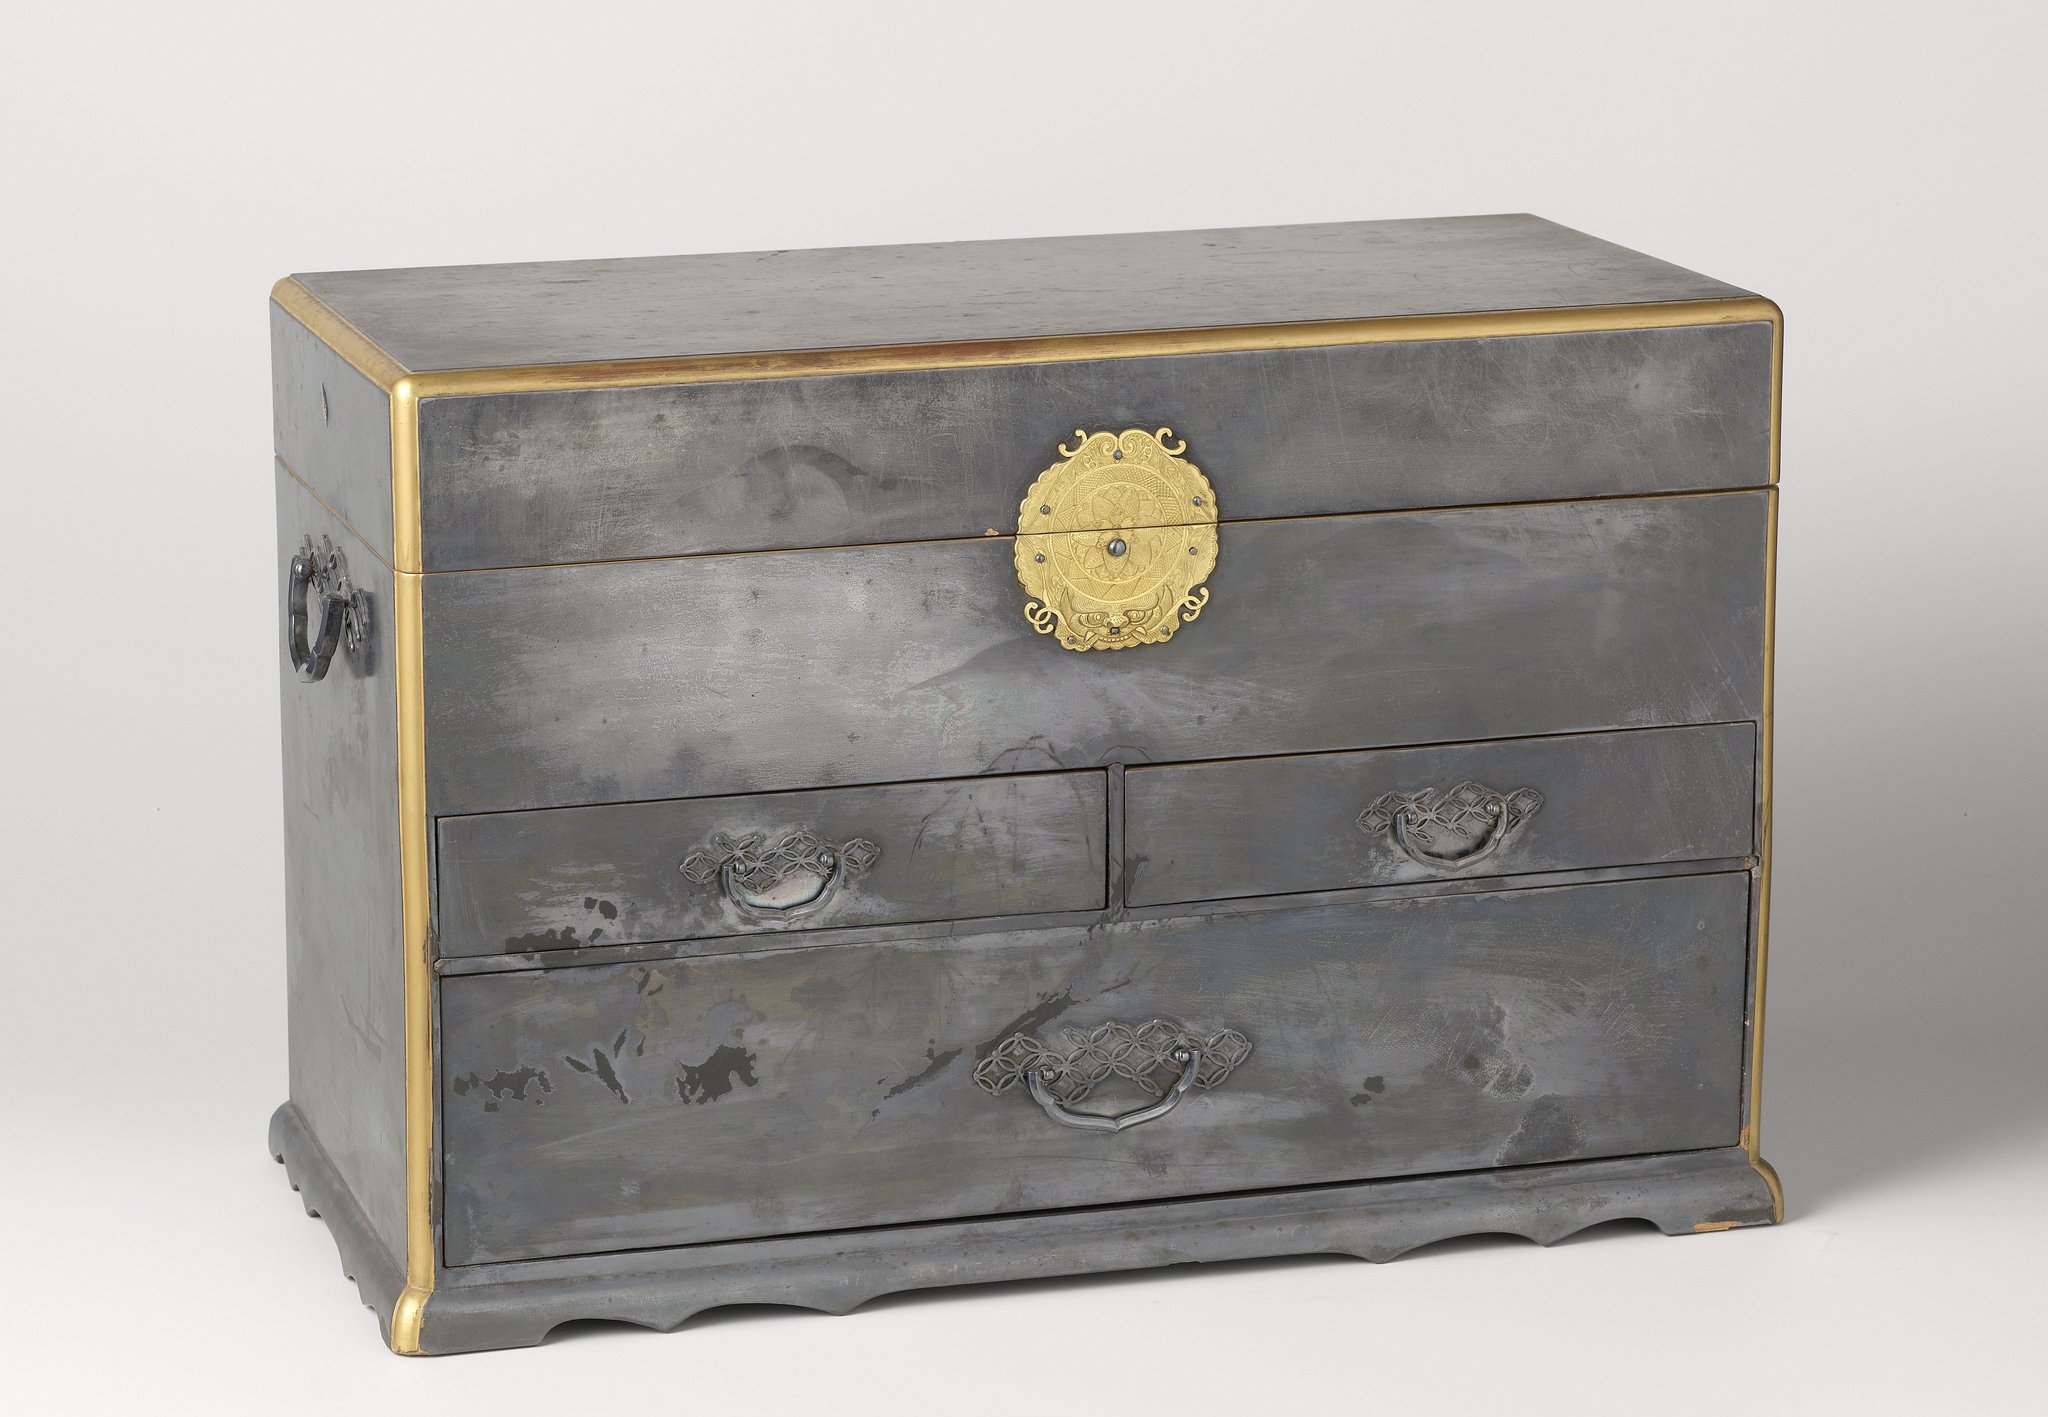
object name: cabinet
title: Kabinet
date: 1700-1850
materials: silver, wood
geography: japan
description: Zilver gelakt kabinetje met zwarte figuren, zilver beslag en vergulde scharnieren.